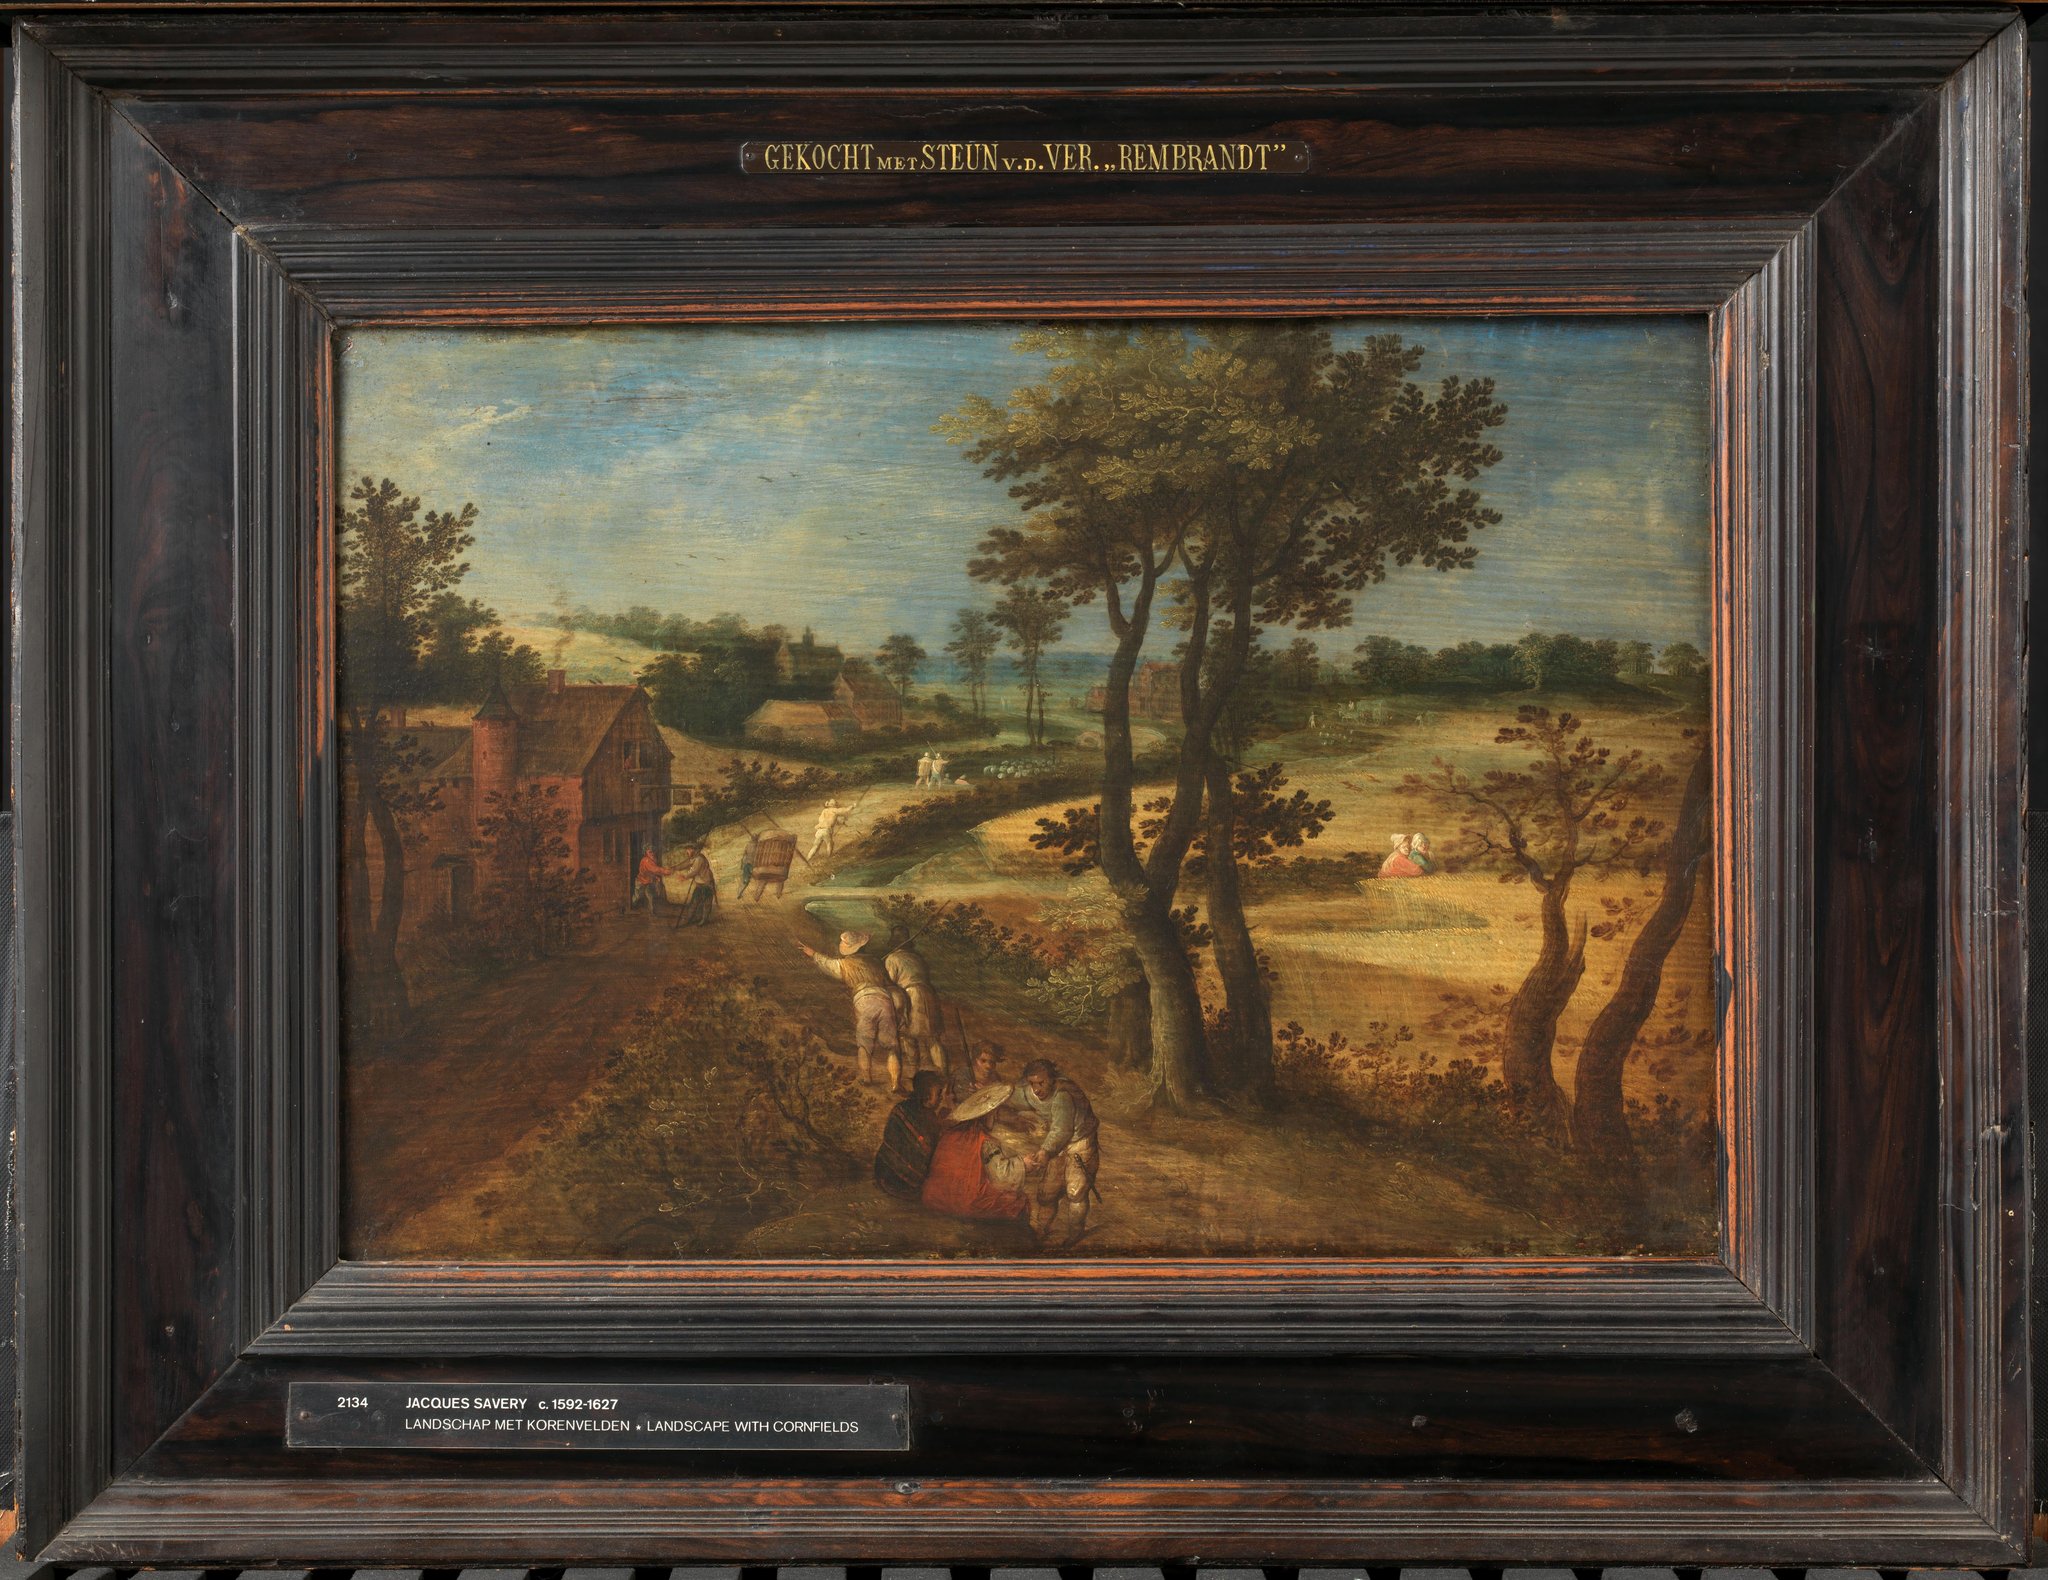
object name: frame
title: Profiellijst van donkerbruin hout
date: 1400-1950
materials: wood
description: Profiellijst van donkerbruin hout met een brede vlakke bodem.